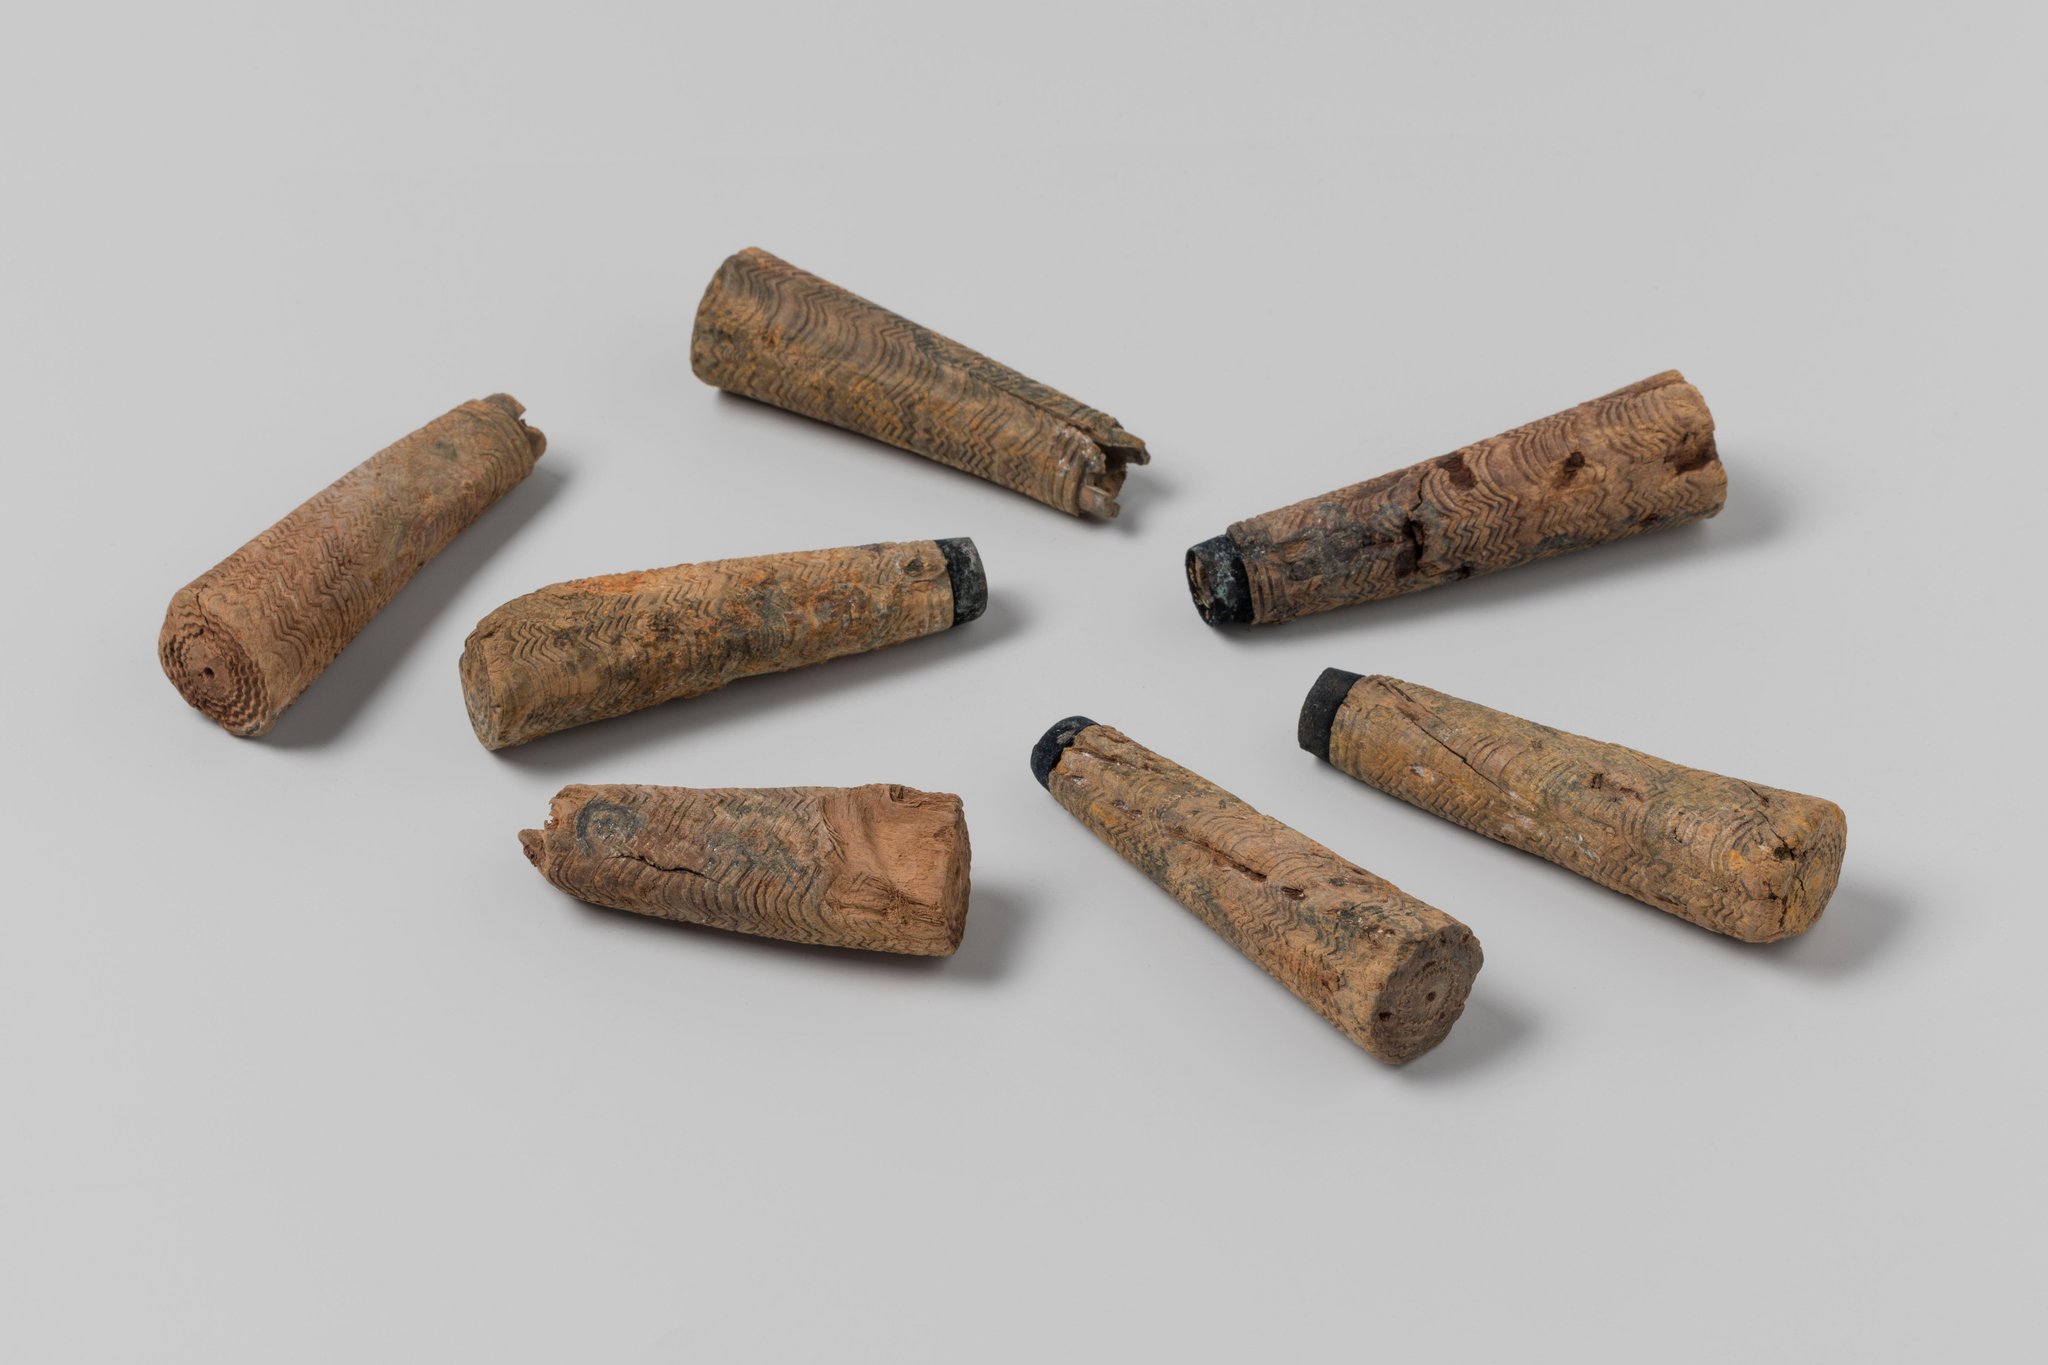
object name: knife handle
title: Messenheften uit het wrak van de Oost-Indiëvaarder Hollandia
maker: Anonymous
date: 1700-1743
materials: metal, wood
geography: netherlands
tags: verenigde oostindische compagnie, hollandia (schip), annet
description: Knife, handle, cylindrical: tapering; flat upper end, turned decoration of separate bands of dense wavy lines, concentric circles at lower end, ferrules, id. NG 1980-27H426.